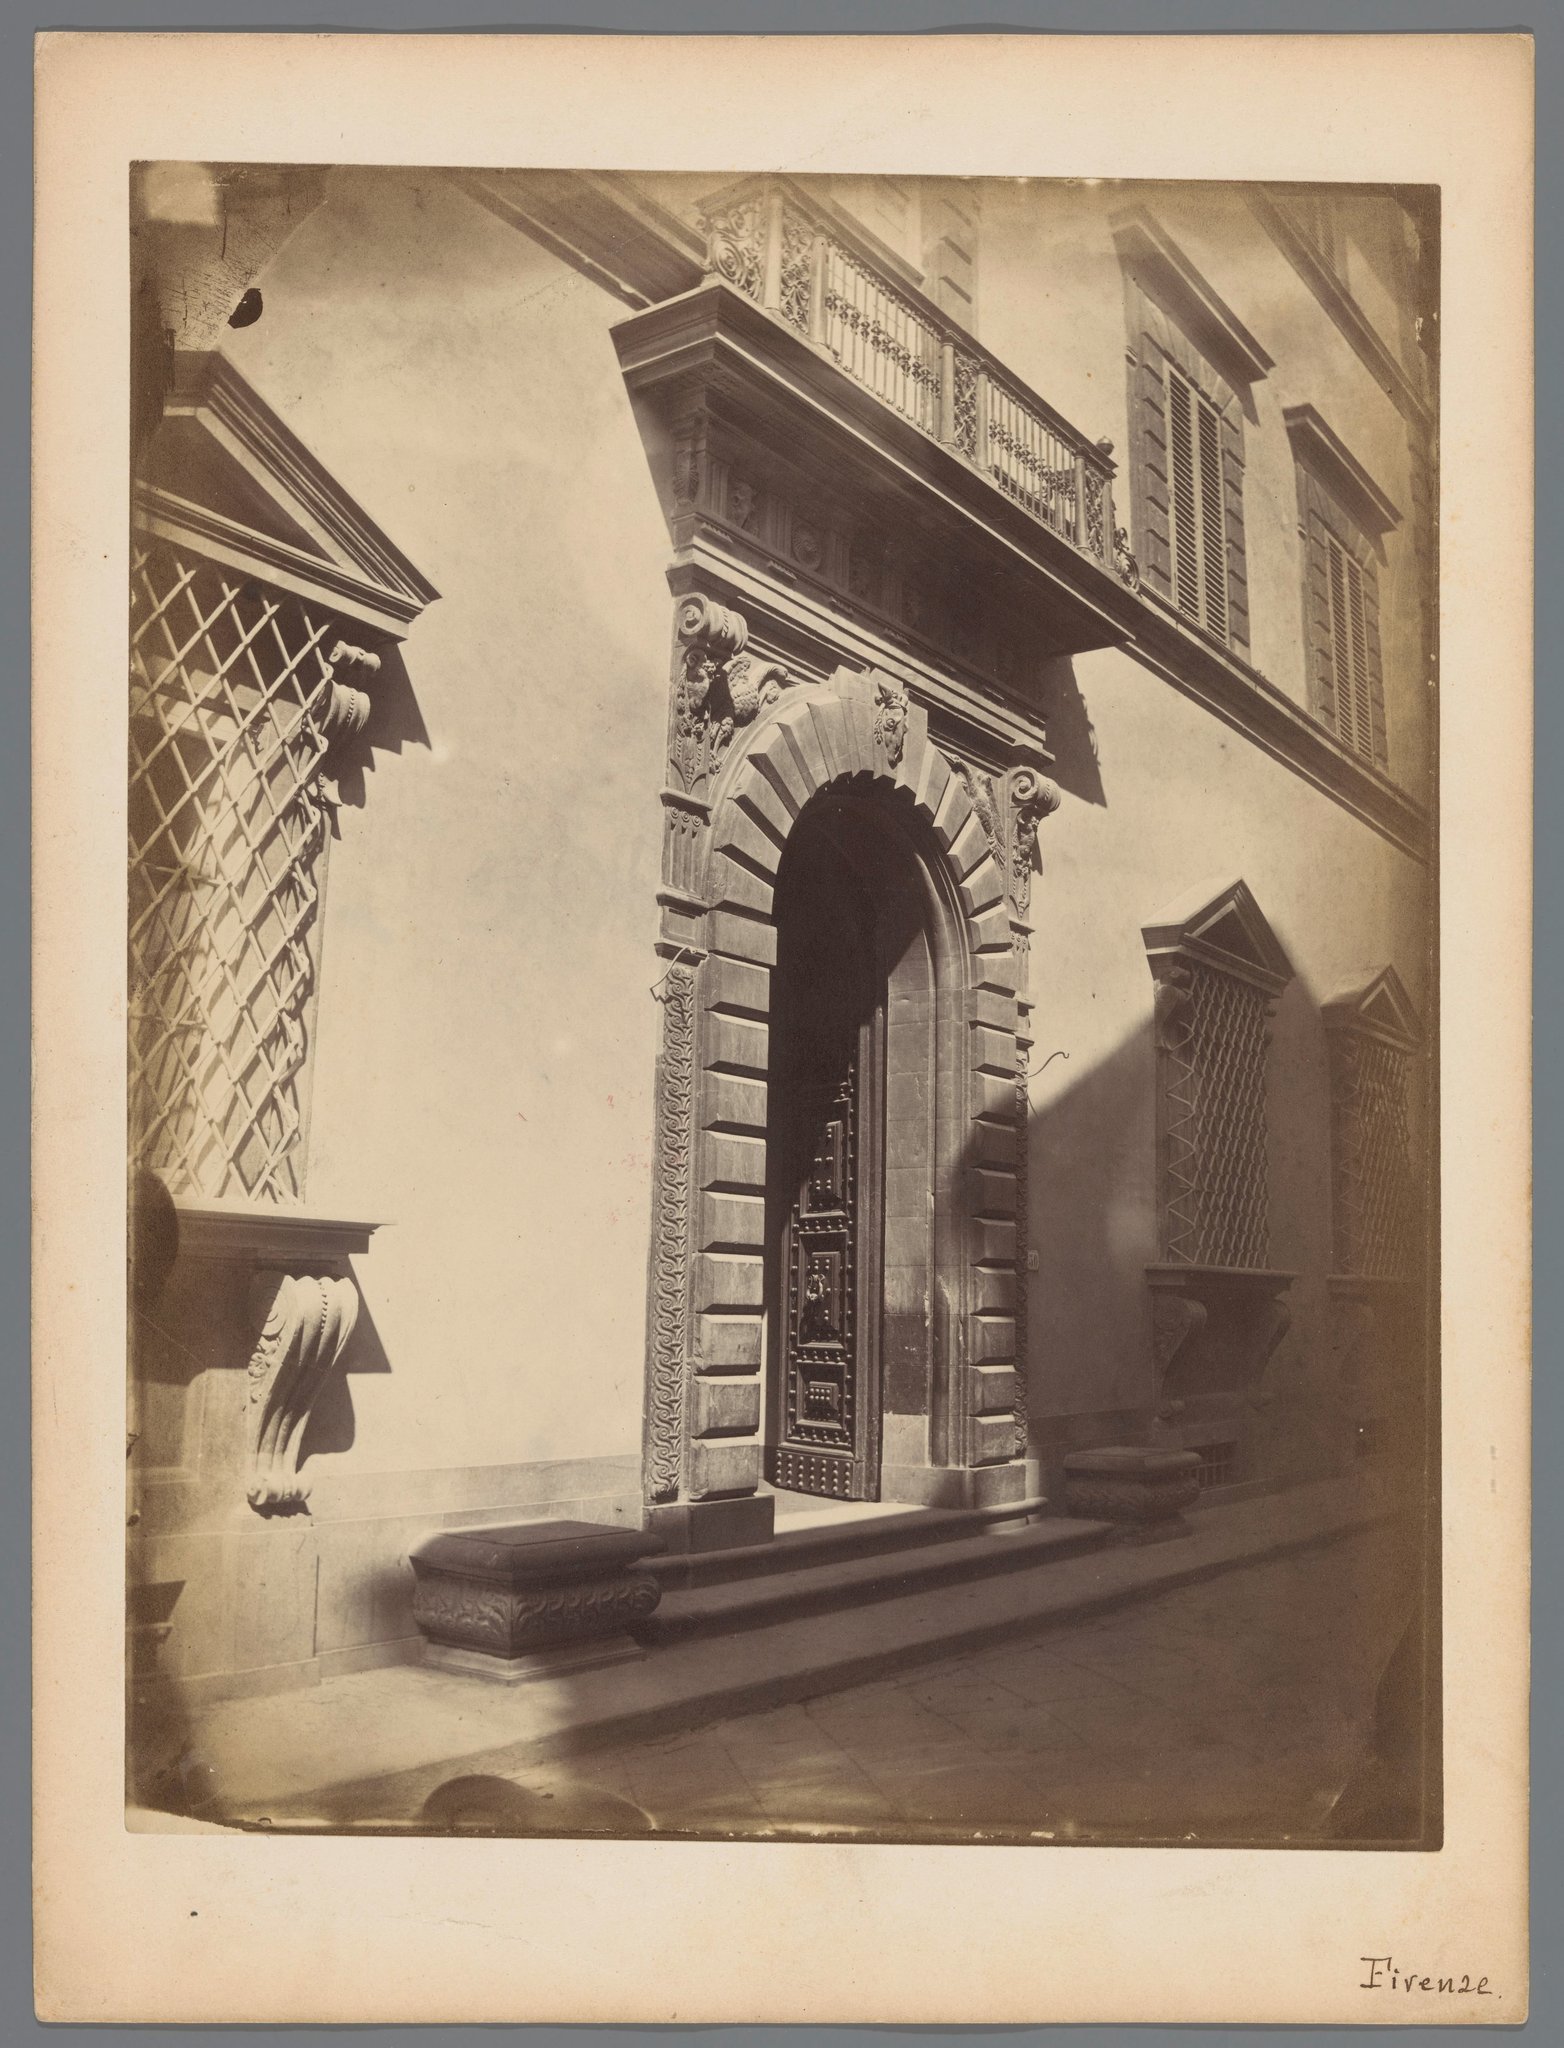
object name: photograph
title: Firenze.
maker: Anonymous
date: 1875-1900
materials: cardboard, photographic support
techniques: albumen print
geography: florence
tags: gate, entrance, balcony, façade (of house or building)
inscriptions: collector's mark: Lugt 3937